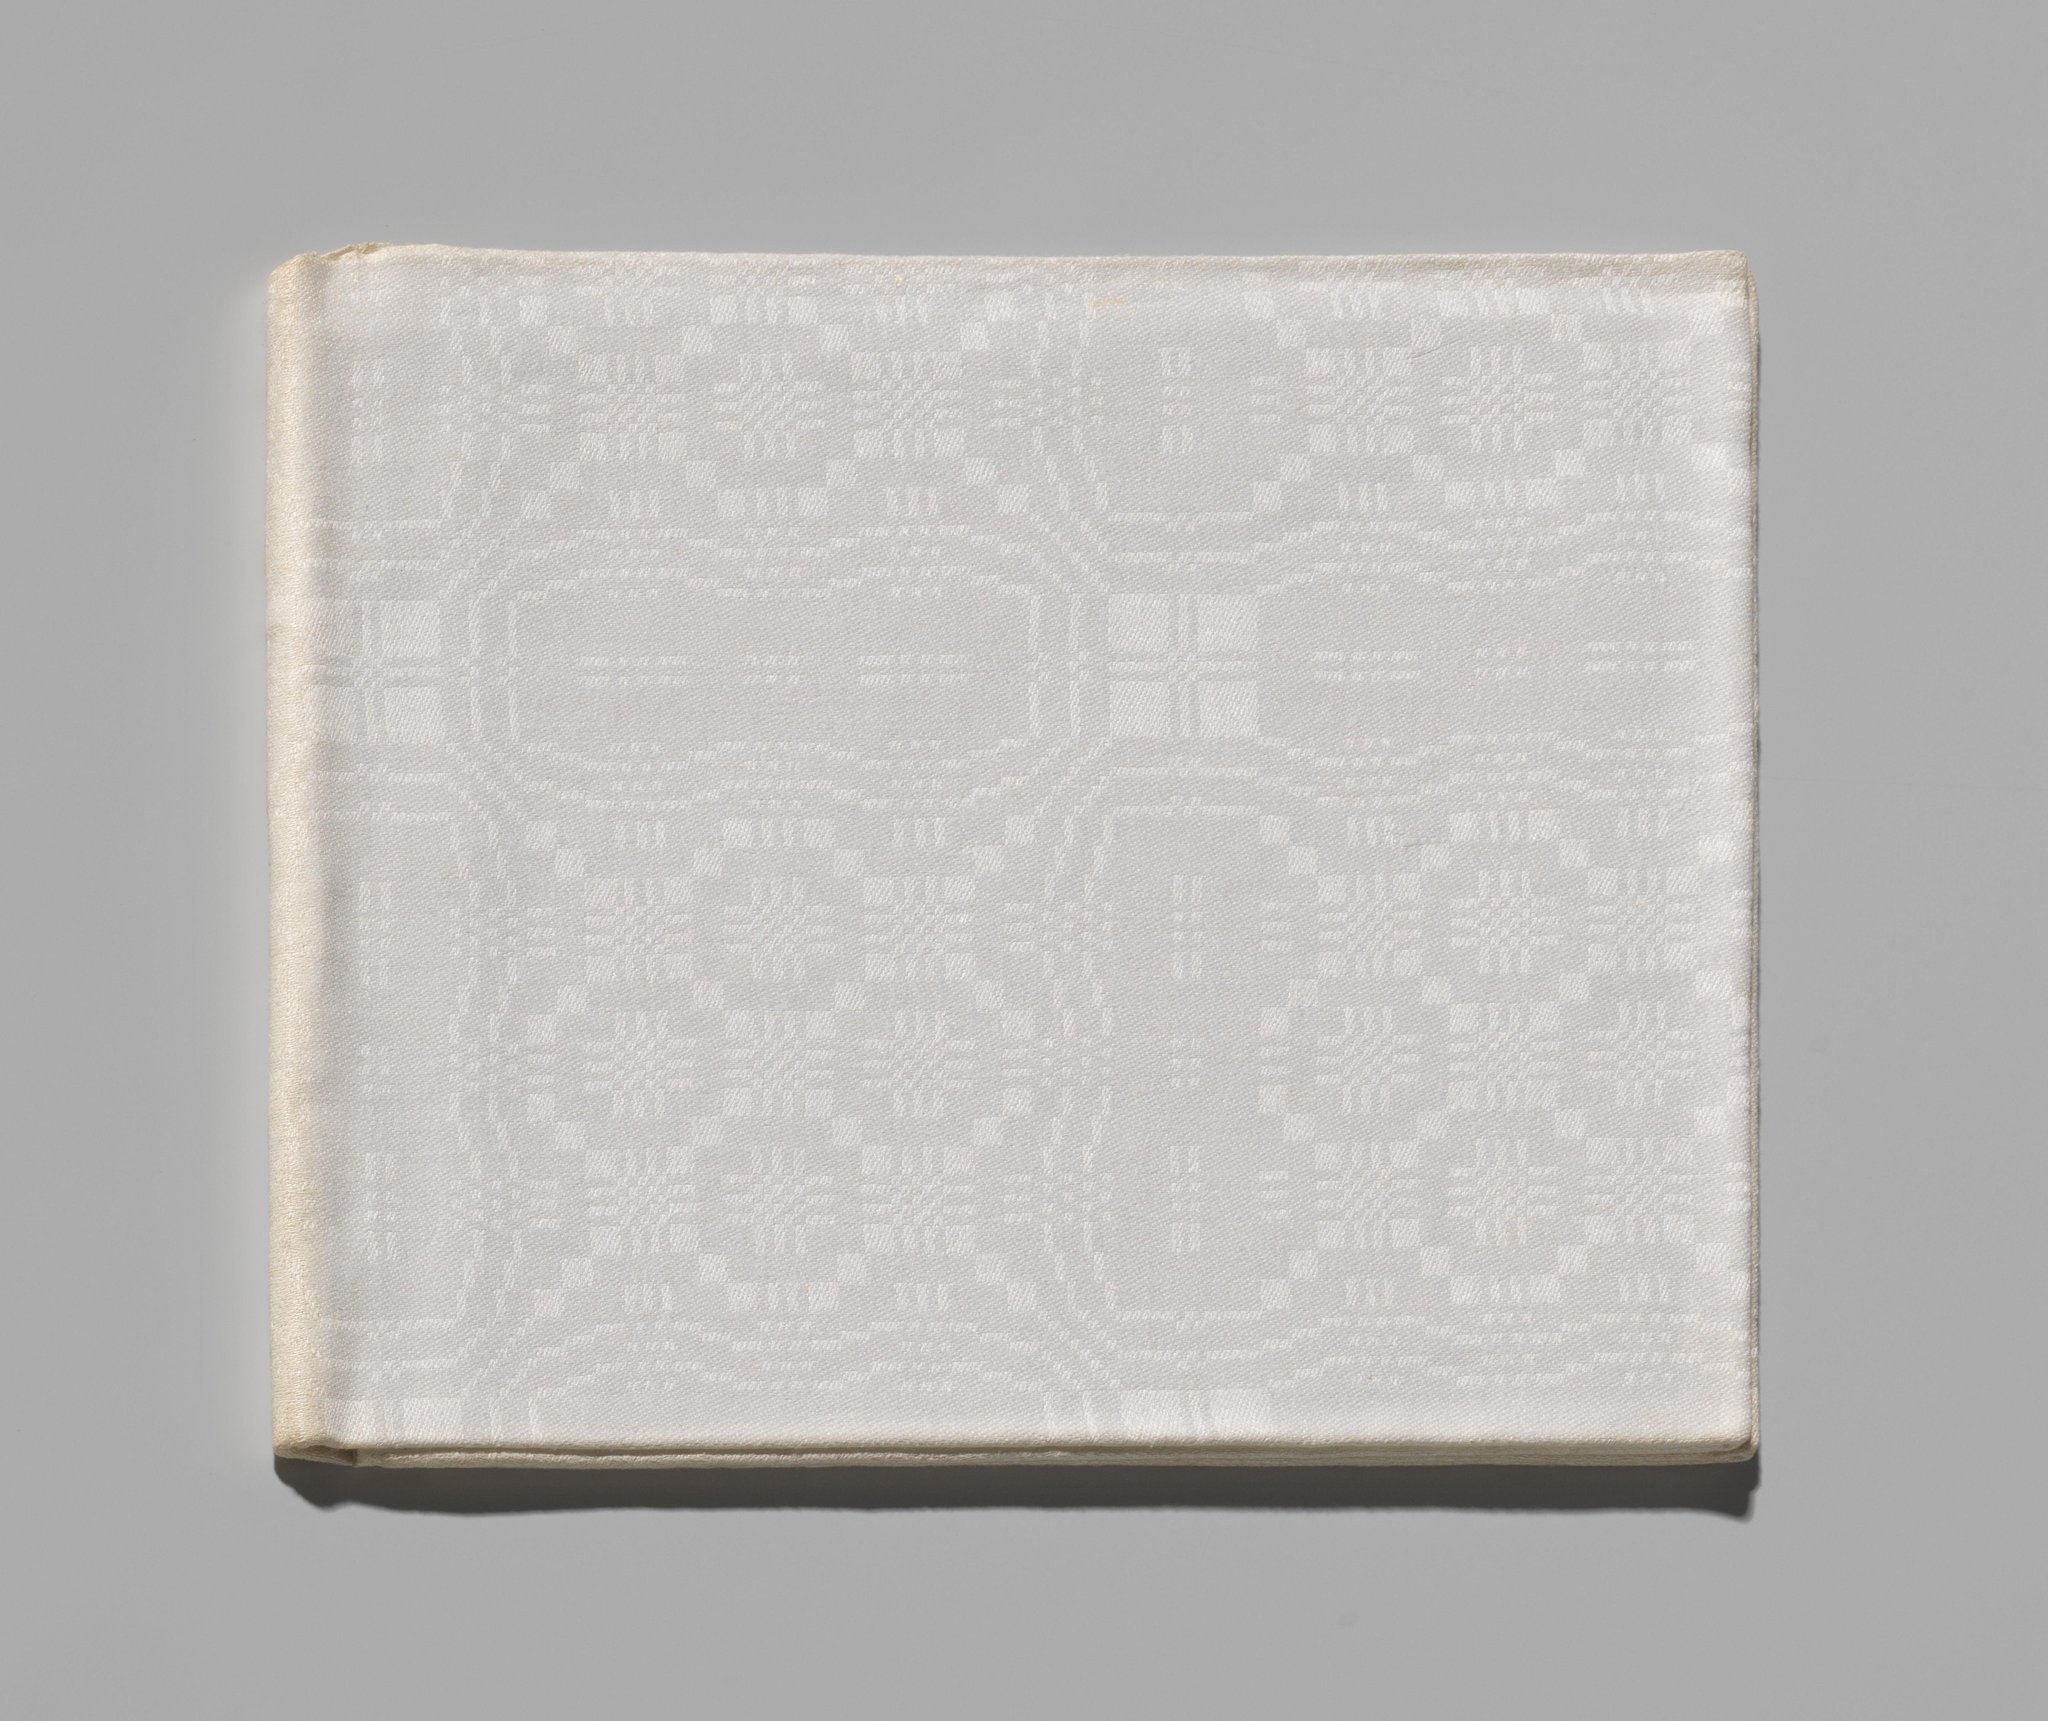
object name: napkin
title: Pellen. Merk geborduurd in de hoek: PP 12.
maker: Anonymous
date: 1800-1900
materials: linen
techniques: weave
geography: netherlands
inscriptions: monogram: ‘PP 12’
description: Servet van linnen pellendamast met randen rondom en in een hoek de geborduurde letters PP 12. Het servet hoort bij vijf servetten (BK-1980-161-A t/m BK-1980-161-F) en een tafellaken (BK-1980-160).